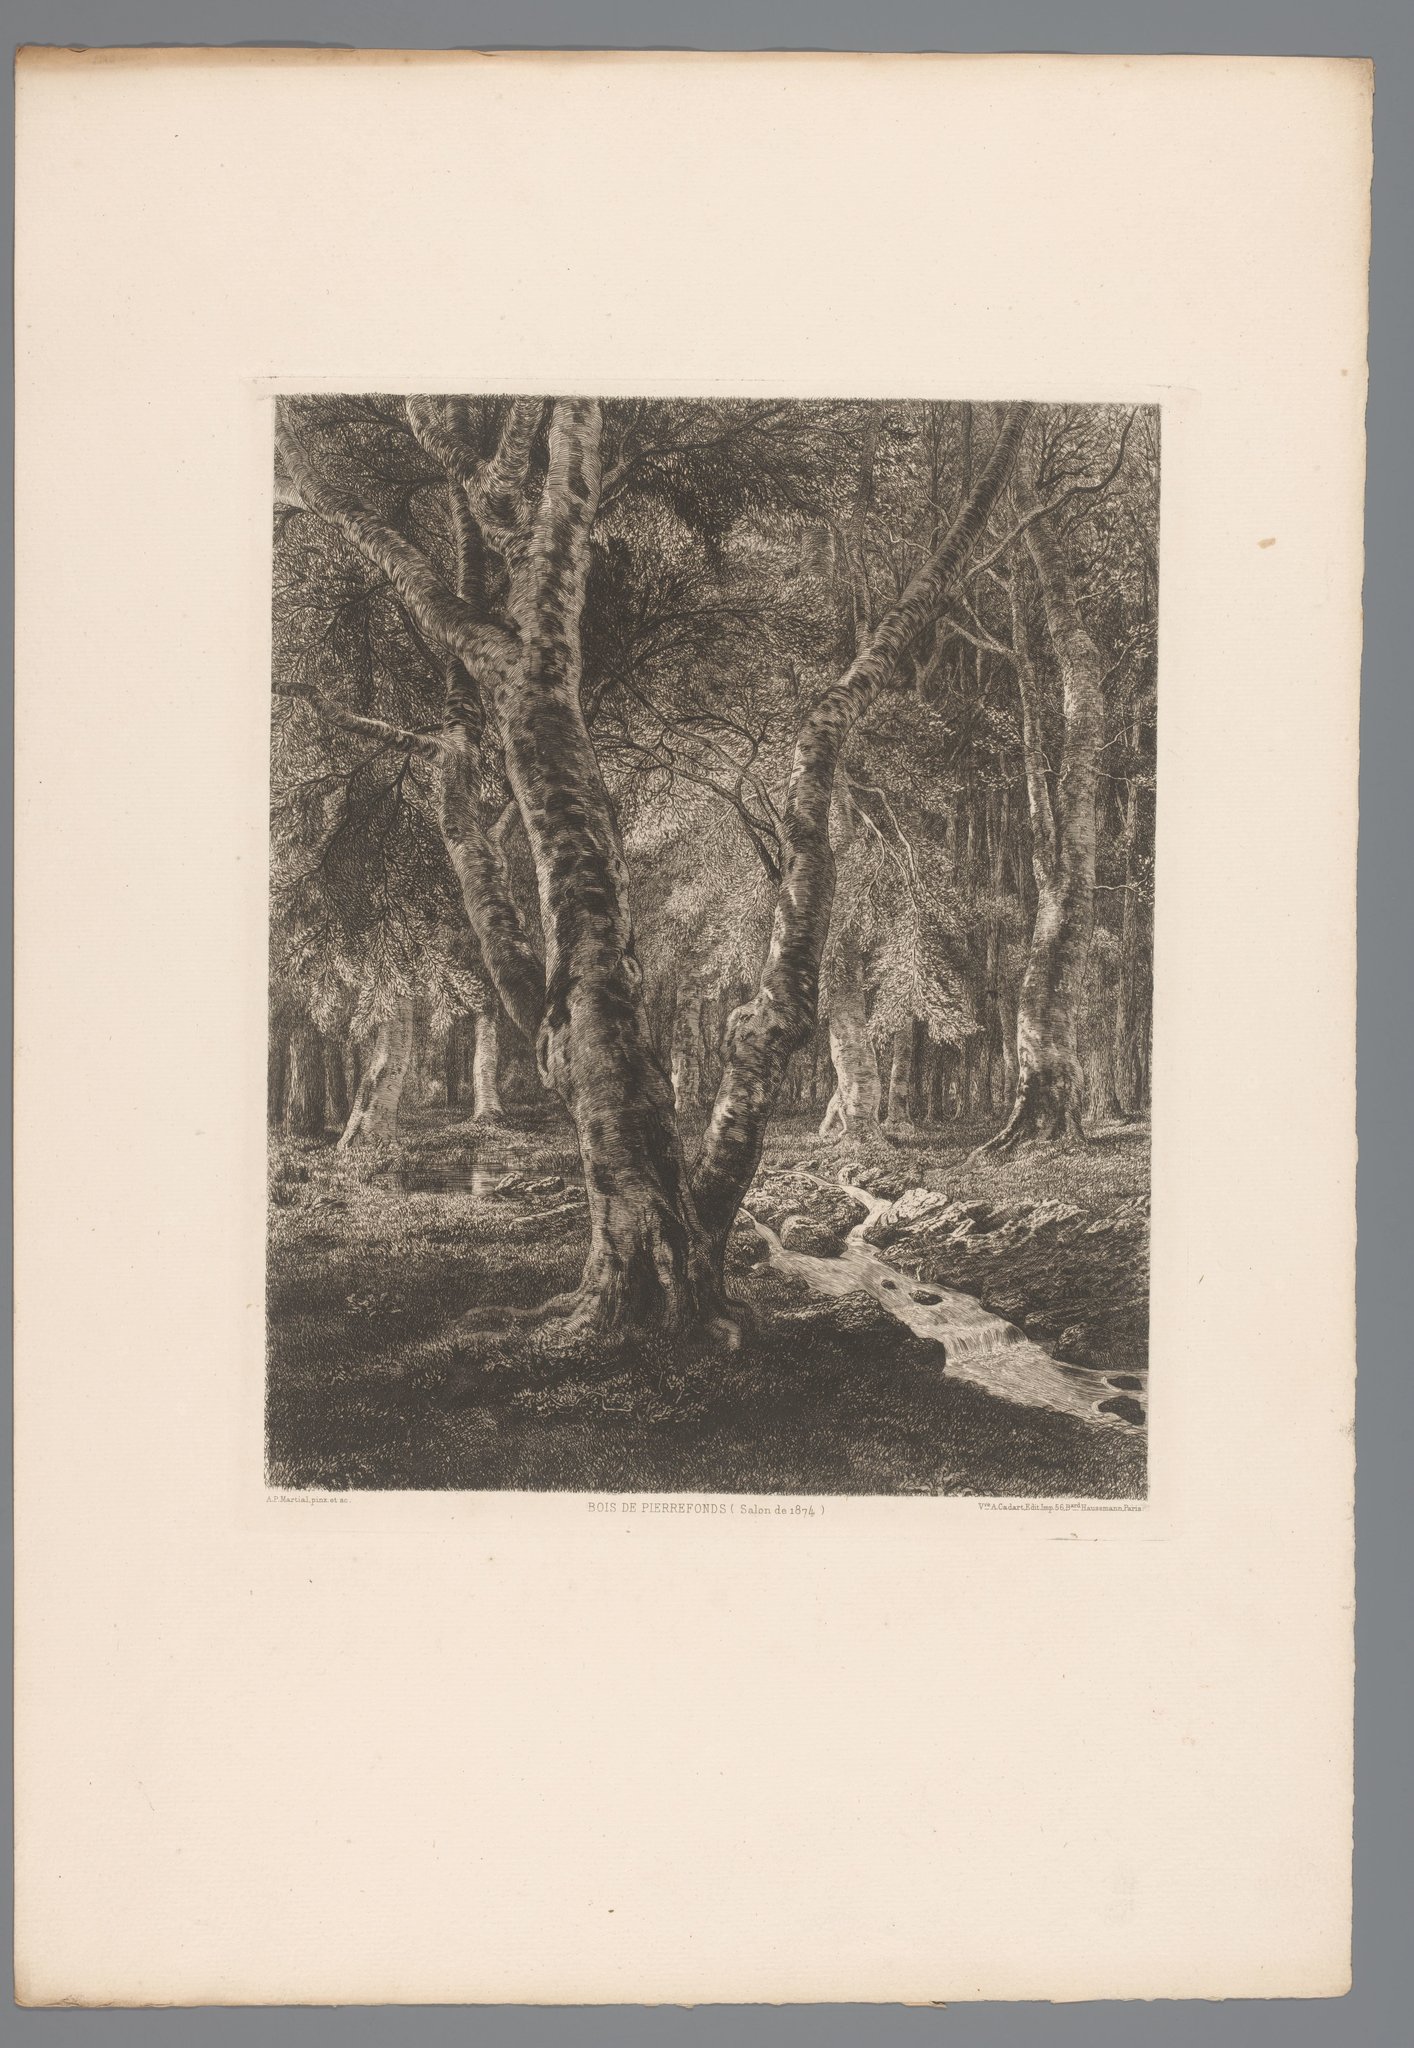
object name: print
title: Franse etsen uit 1876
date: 1876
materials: paper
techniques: drypoint, etching, intaglio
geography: paris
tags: forest, wood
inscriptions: collector's mark: Lugt 2228, collector's mark: Lugt 2760, watermark, collector's mark: ‘AFE v S’